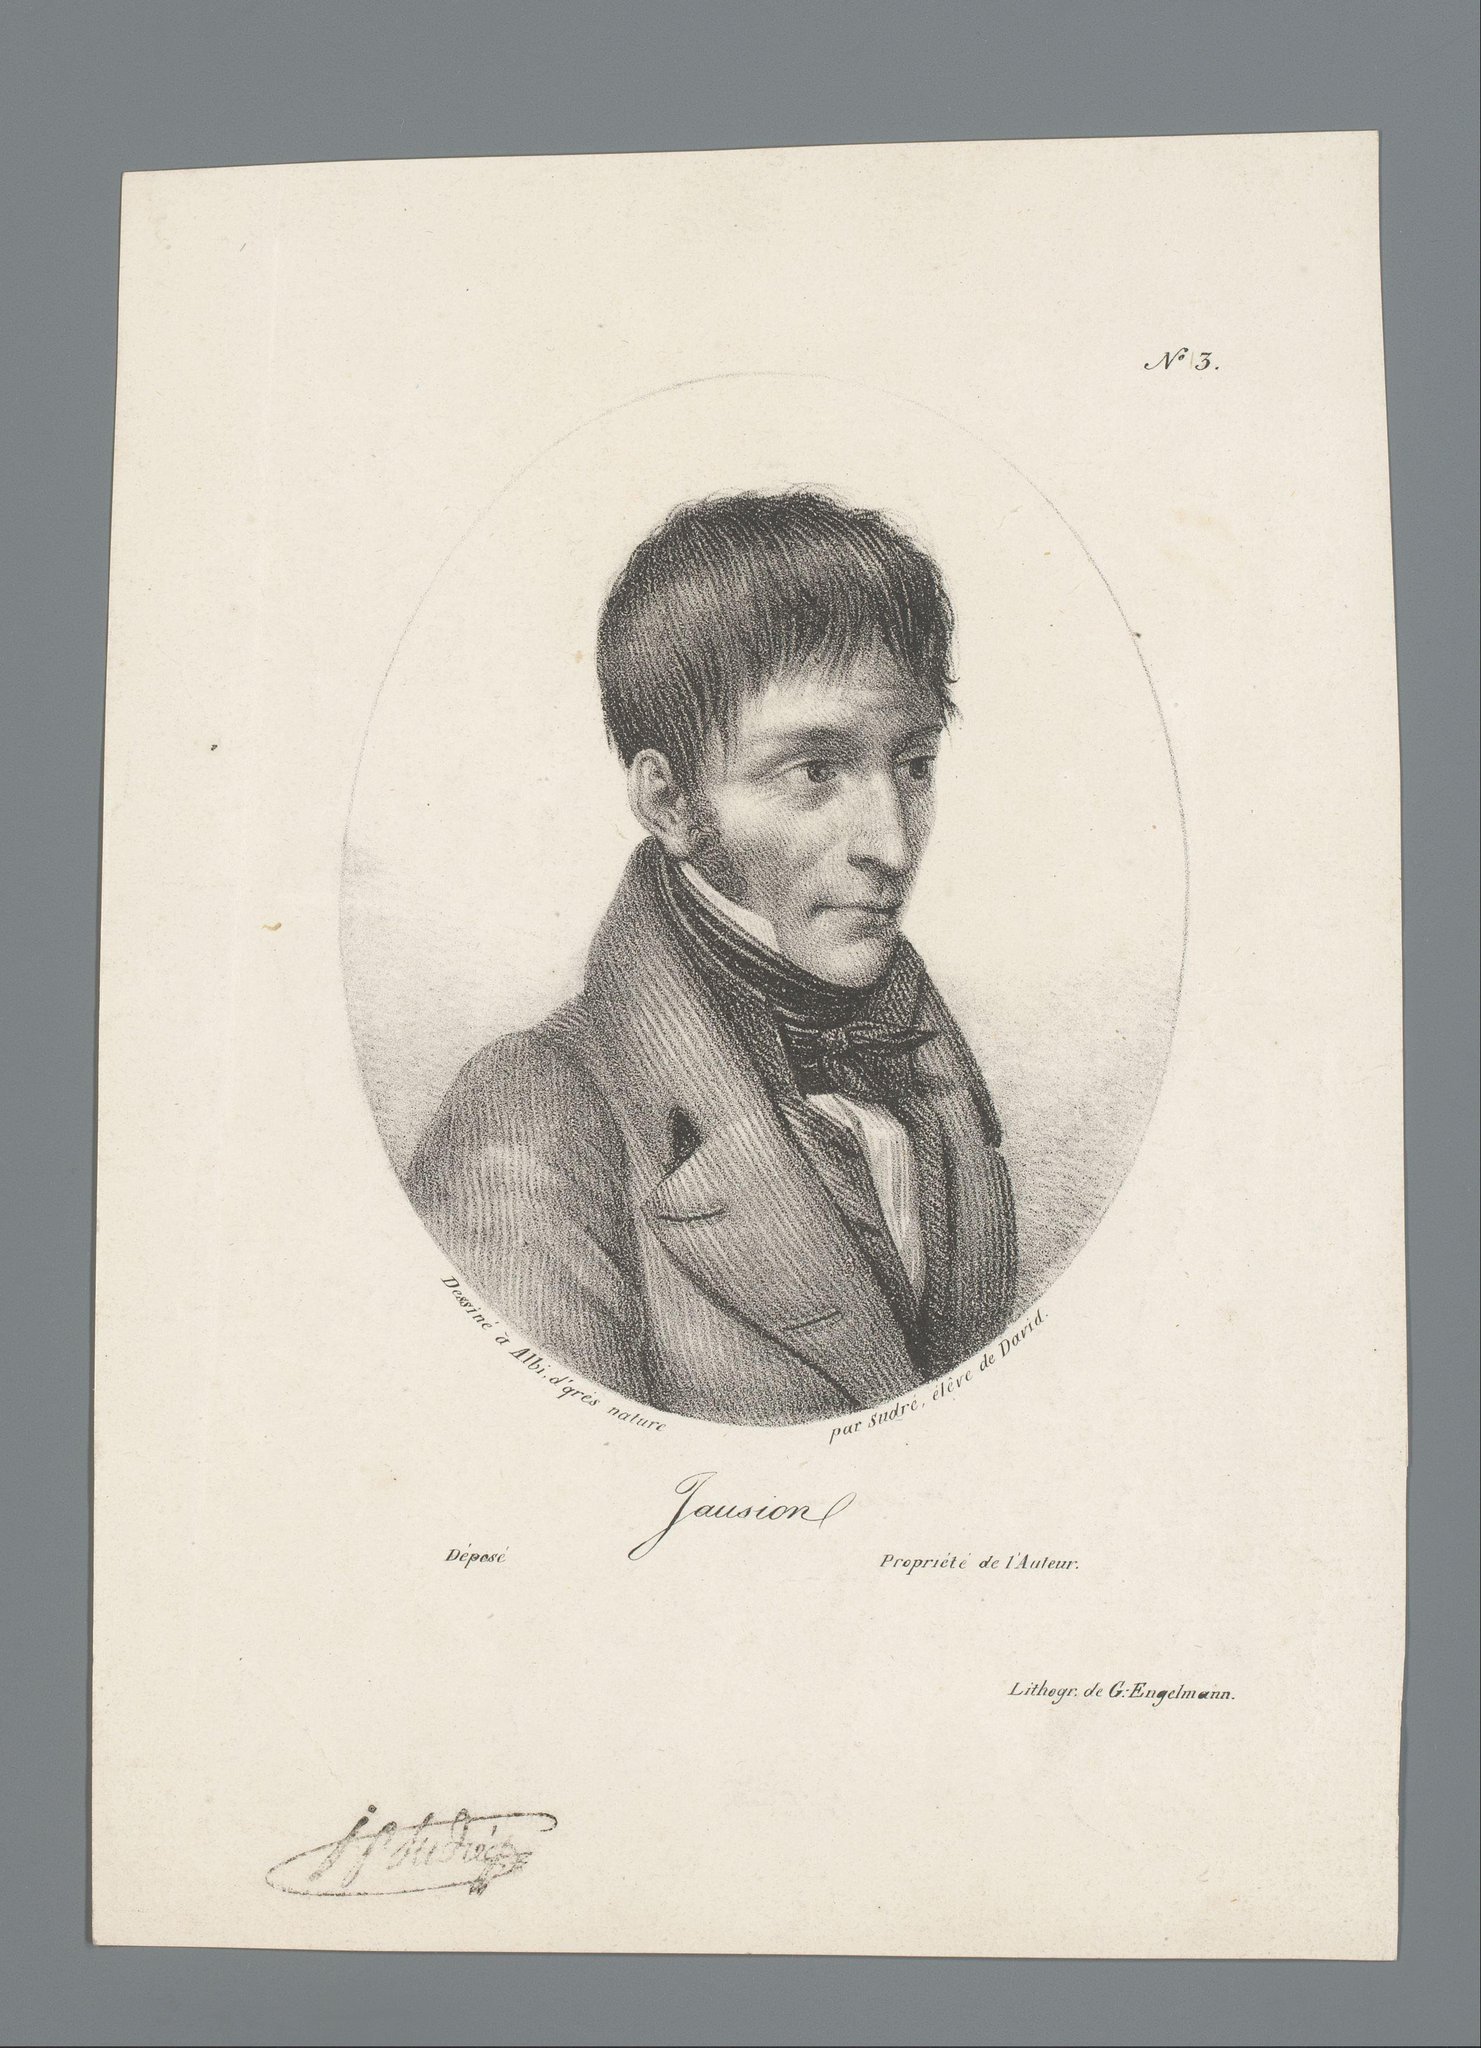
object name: print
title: Hoofdpersonages in de affaire-Fualdès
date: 1818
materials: paper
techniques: lithograph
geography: paris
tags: historical persons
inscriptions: stamp: Lugt 2325b, collector's mark: Lugt 2228